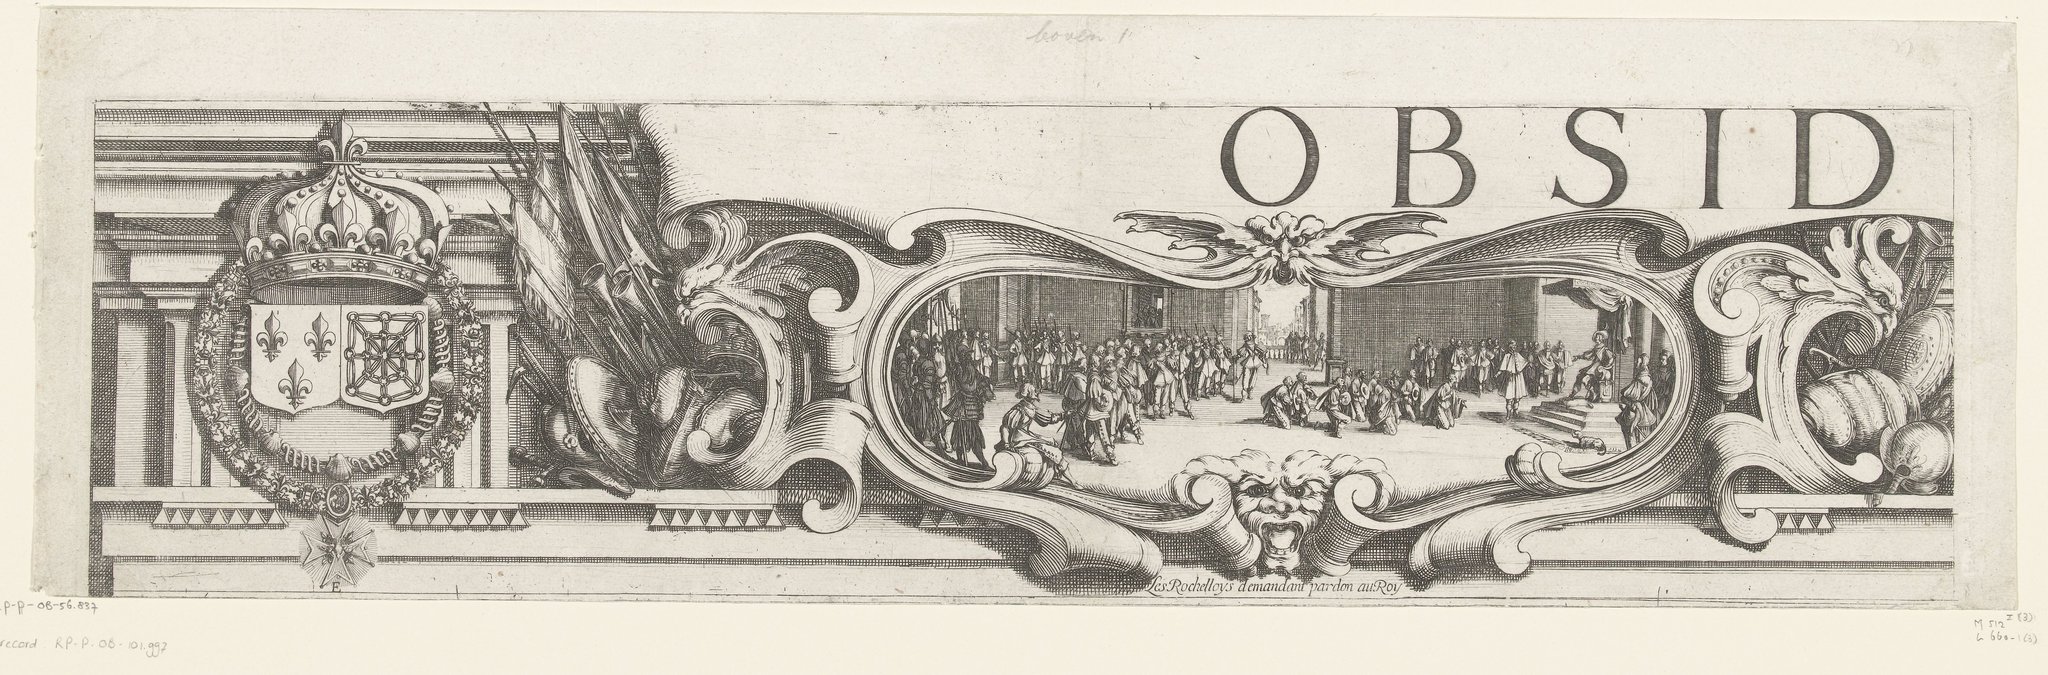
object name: history print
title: Les Rochelloys demandant pardon au Roy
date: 1628-1631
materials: paper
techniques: engraving, etching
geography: paris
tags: paris, armand-jean du plessis hertog van richelieu, lodewijk xiii (koning van frankrijk), ornament ~ cartouche, the defeated before the victor, armorial bearing, heraldry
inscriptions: collector's mark: Lugt 240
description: Zestiende deel (randwerk, deel linksboven) van een prent van het beleg van het hugenotenbolwerk La Rochelle in de jaren 1627 en 1628, dat werd uitgevoerd in opdracht van de Franse koning door het Franse leger onder aanvoering van kardinaal Richelieu. Op dit blad links het wapen van Lodewijk XIII en midden/rechts een voorstelling (omgeven door militaire attributen) van bewoners van La Rochelle die de koning om genade smeken. Rechtsboven de letters 'OBSID', een deel van het opschrift van de prent.